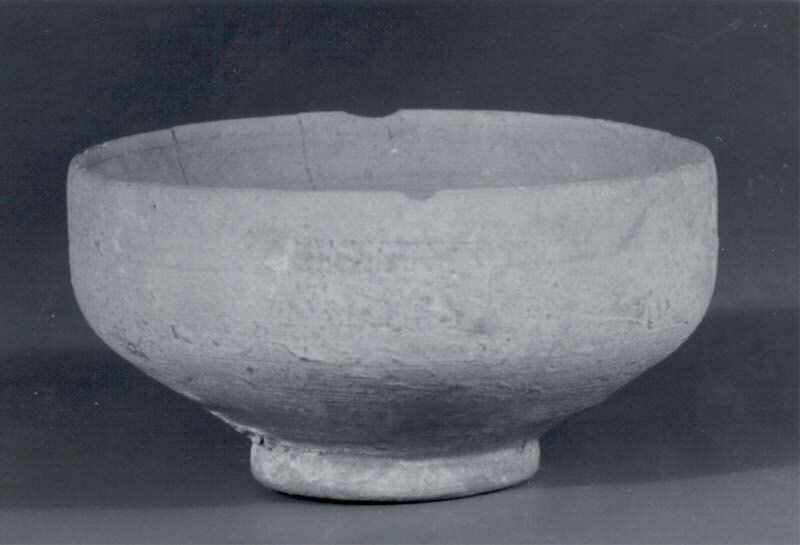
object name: bowl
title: Small bowl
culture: nabataean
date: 1-100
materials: ceramic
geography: levant